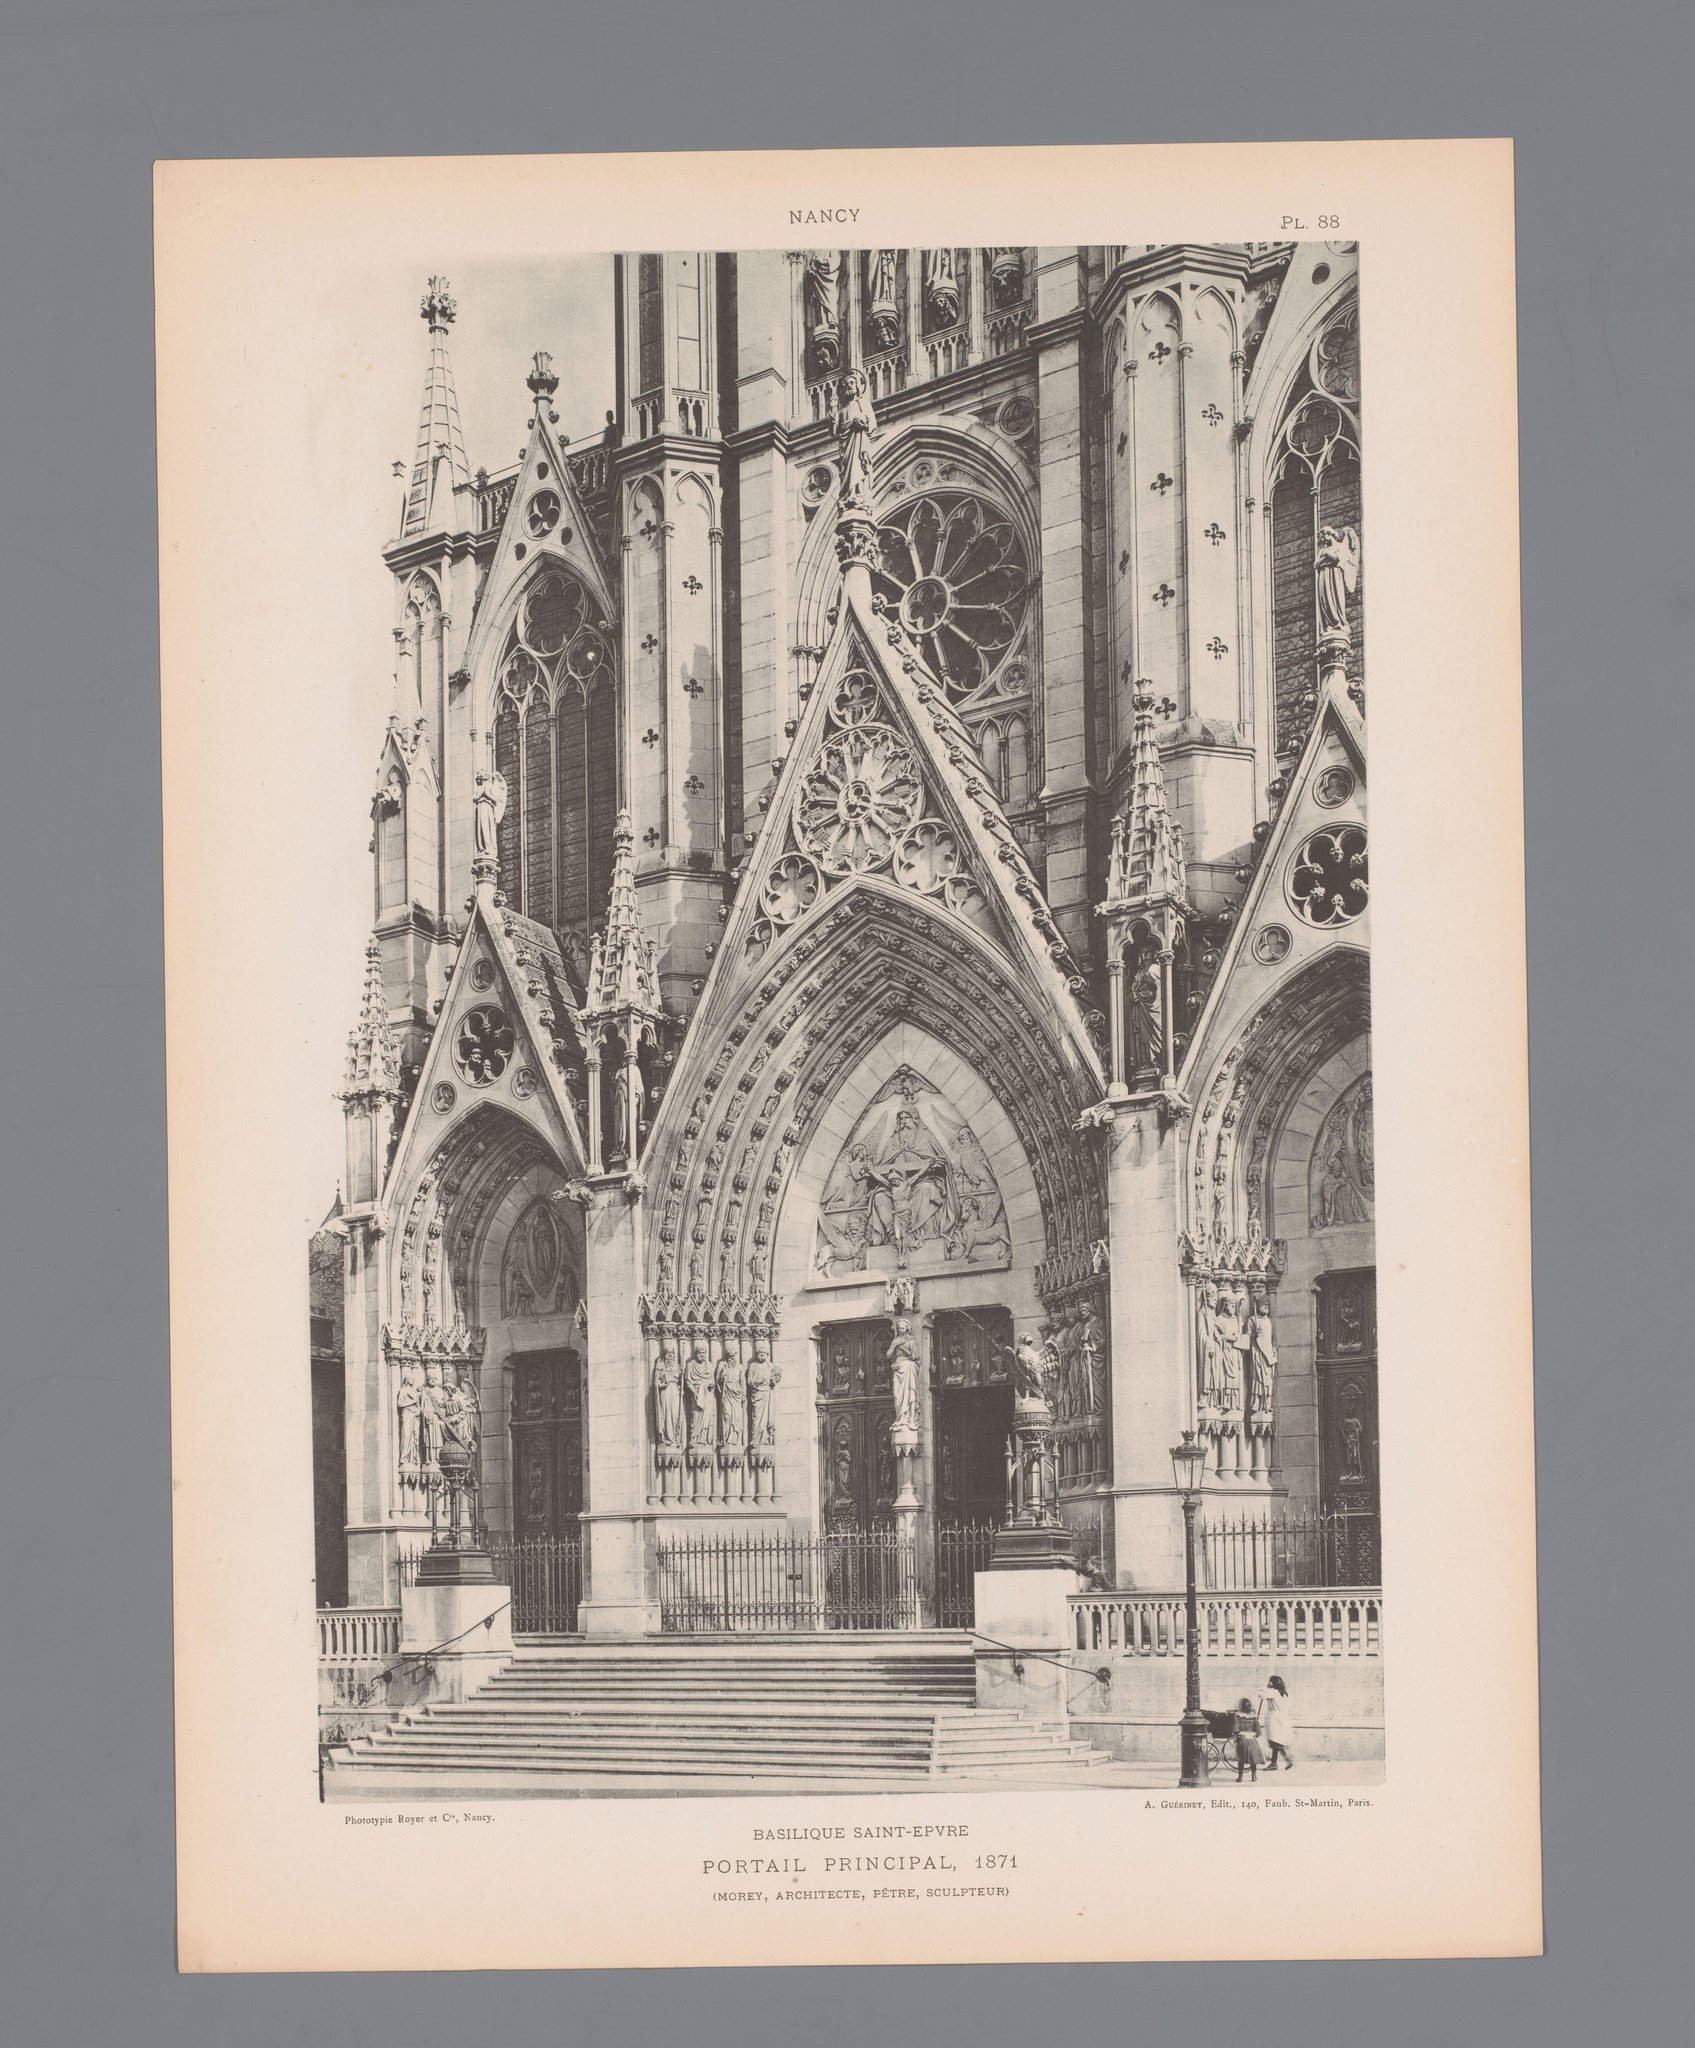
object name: photomechanical print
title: Portaal van de Basilique Saint-Epvre te Nancy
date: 1891-1896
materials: paper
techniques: photograph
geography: paris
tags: parts of church exterior and annexes: portal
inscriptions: inscription: ‘Basilique Saint-Epvre/ Portail principal, 1871/ (Morey, architecture, Pêtre, sculpteur)’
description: Deze prent maakt deel uit van een omslag met 103 prenten op 101 bladen en een titelblad.